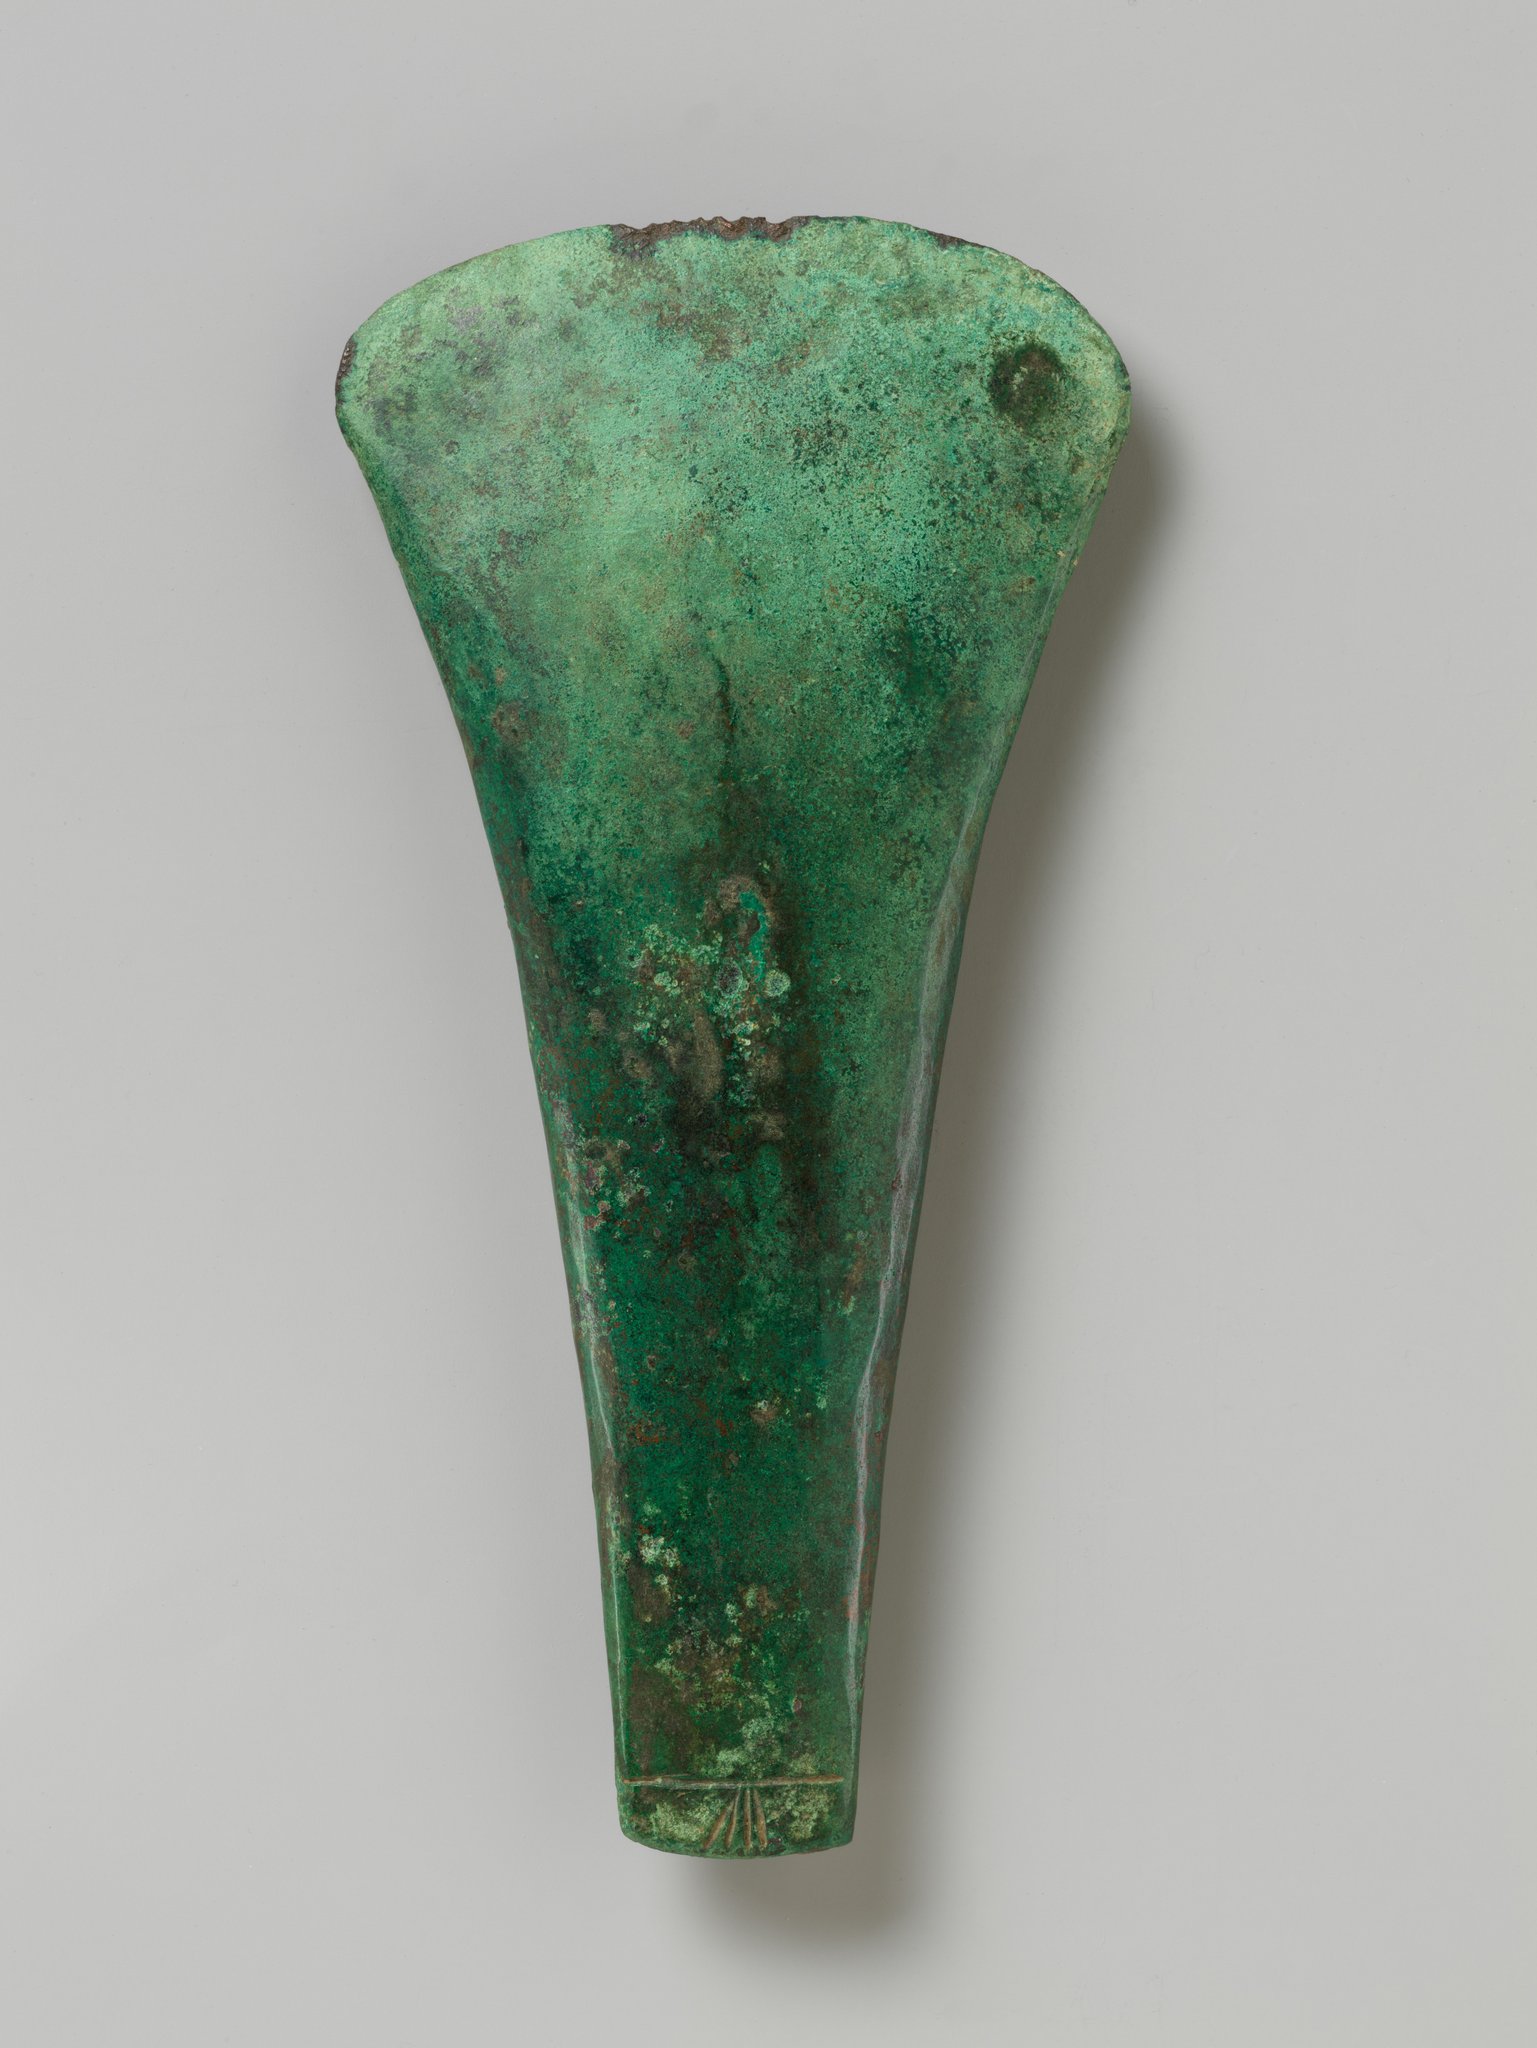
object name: ax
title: Ax Blade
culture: indian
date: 1500-1000 BCE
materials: copper